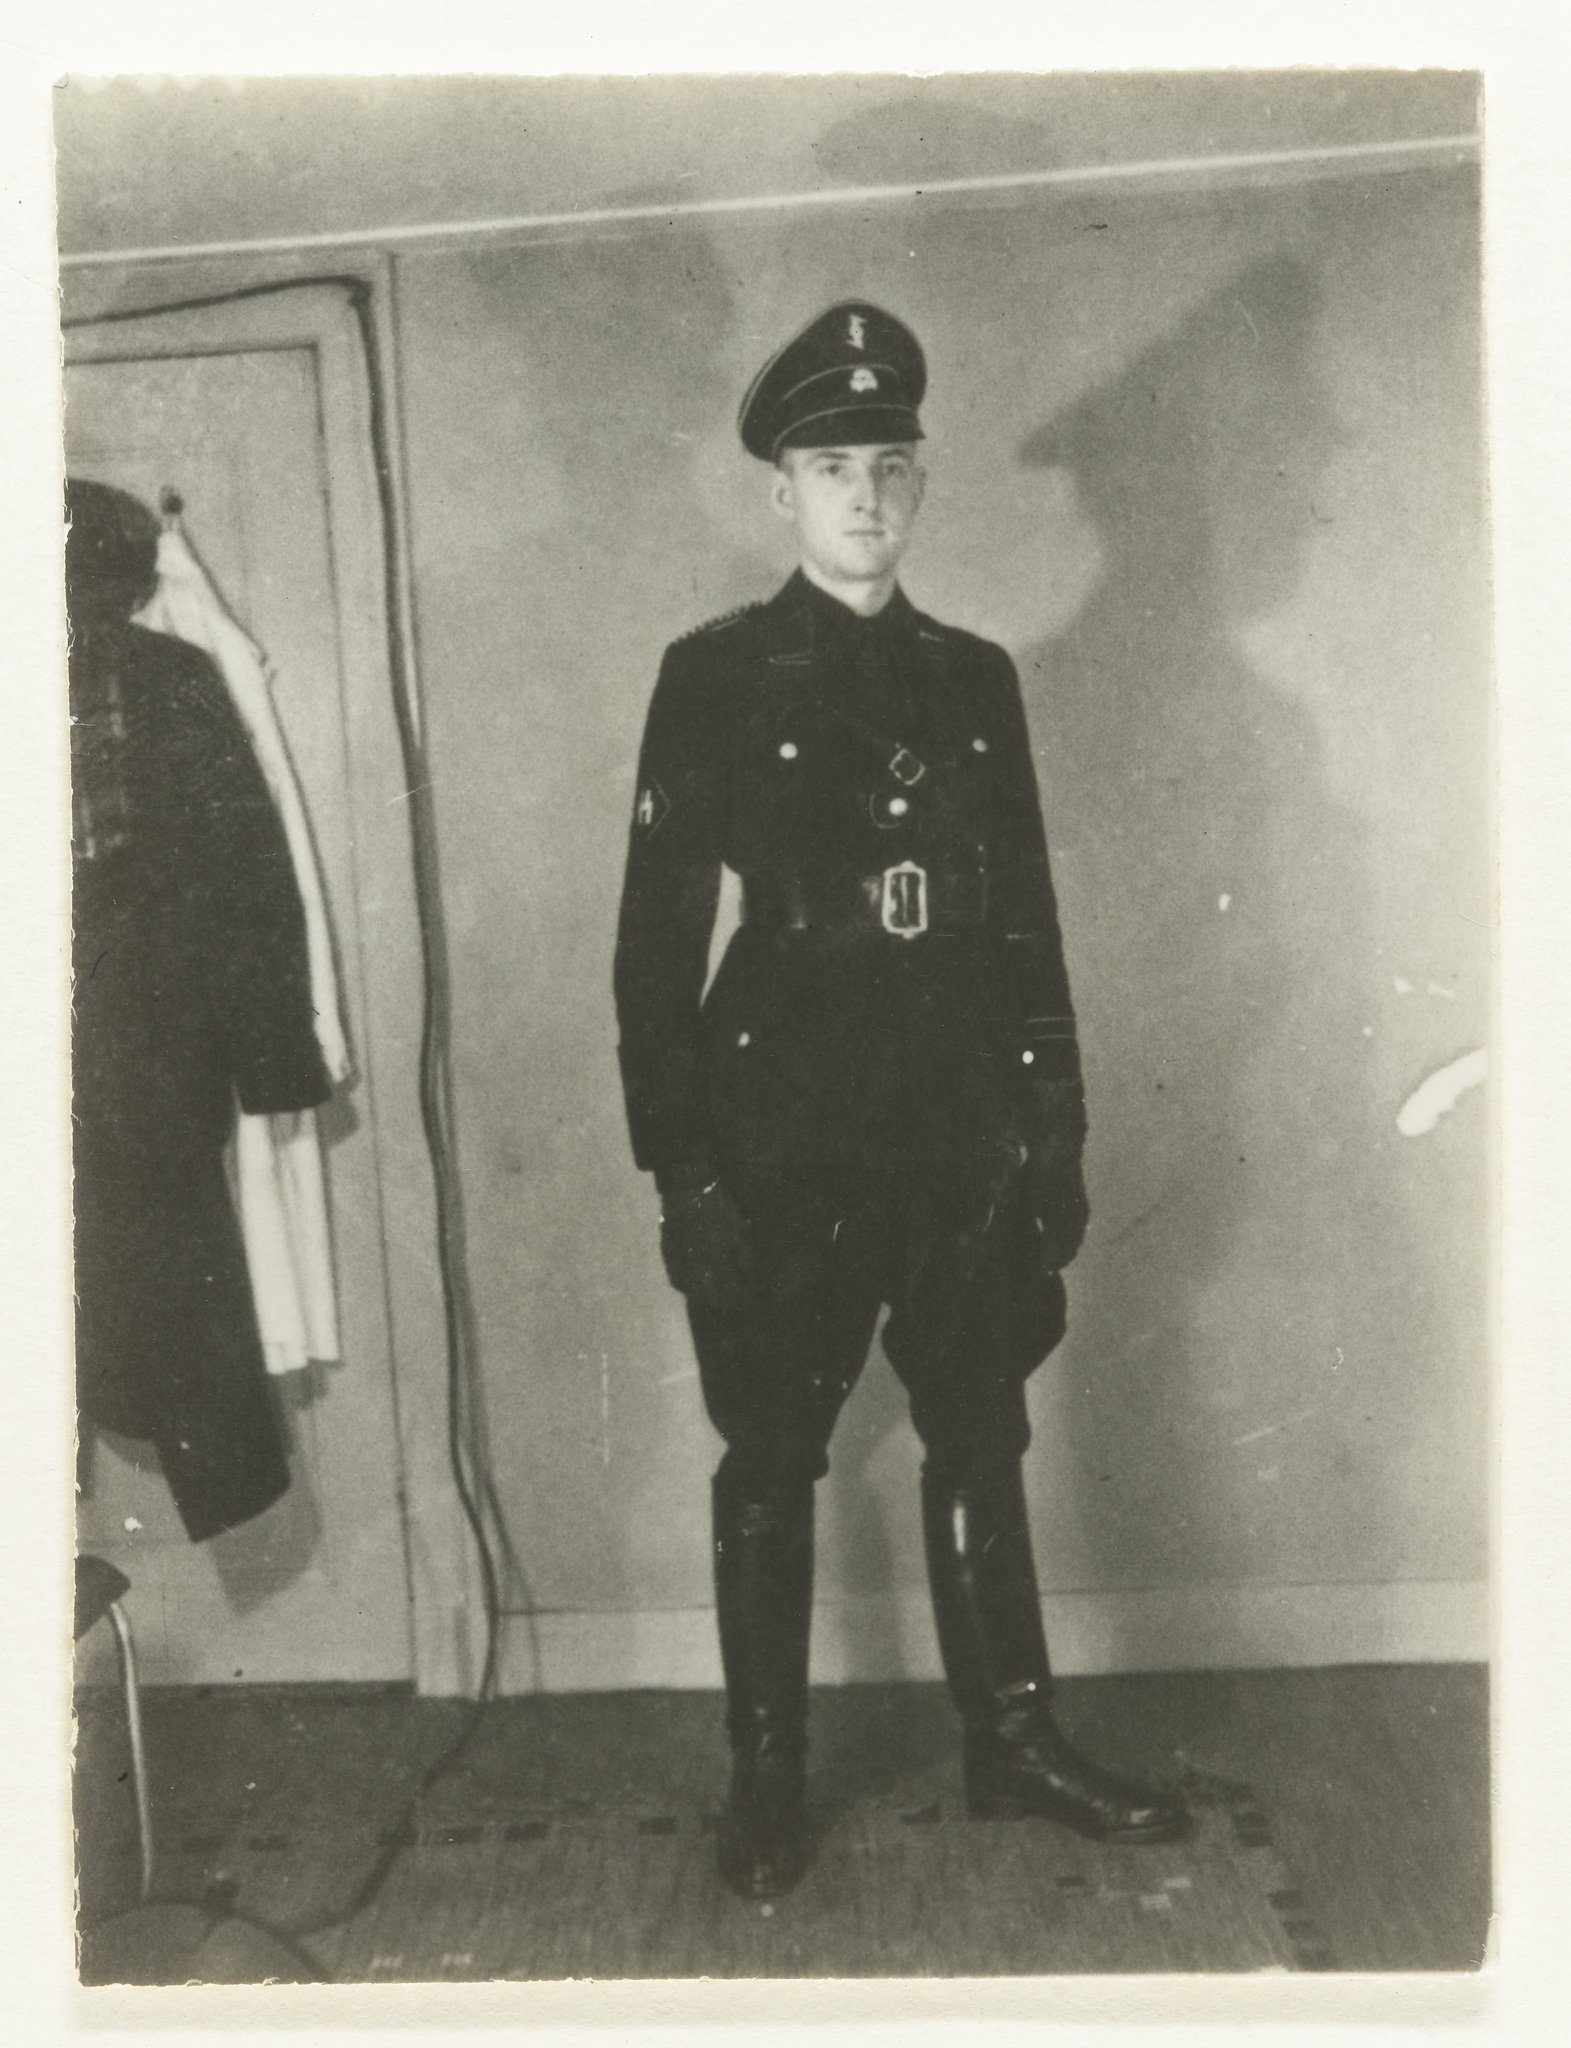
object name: contact print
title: NSB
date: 1940-1944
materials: photographic support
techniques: gelatin silver print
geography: netherlands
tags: anonymous historical person portrayed, netherlands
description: Portret van een lid van de WA Iepenburg (zie opschrift achterzijde). Ten voeten uit gefotografeerd. In uniform van de WA, met pet met wolfsangel. Links van hem hangen burgerkleren.